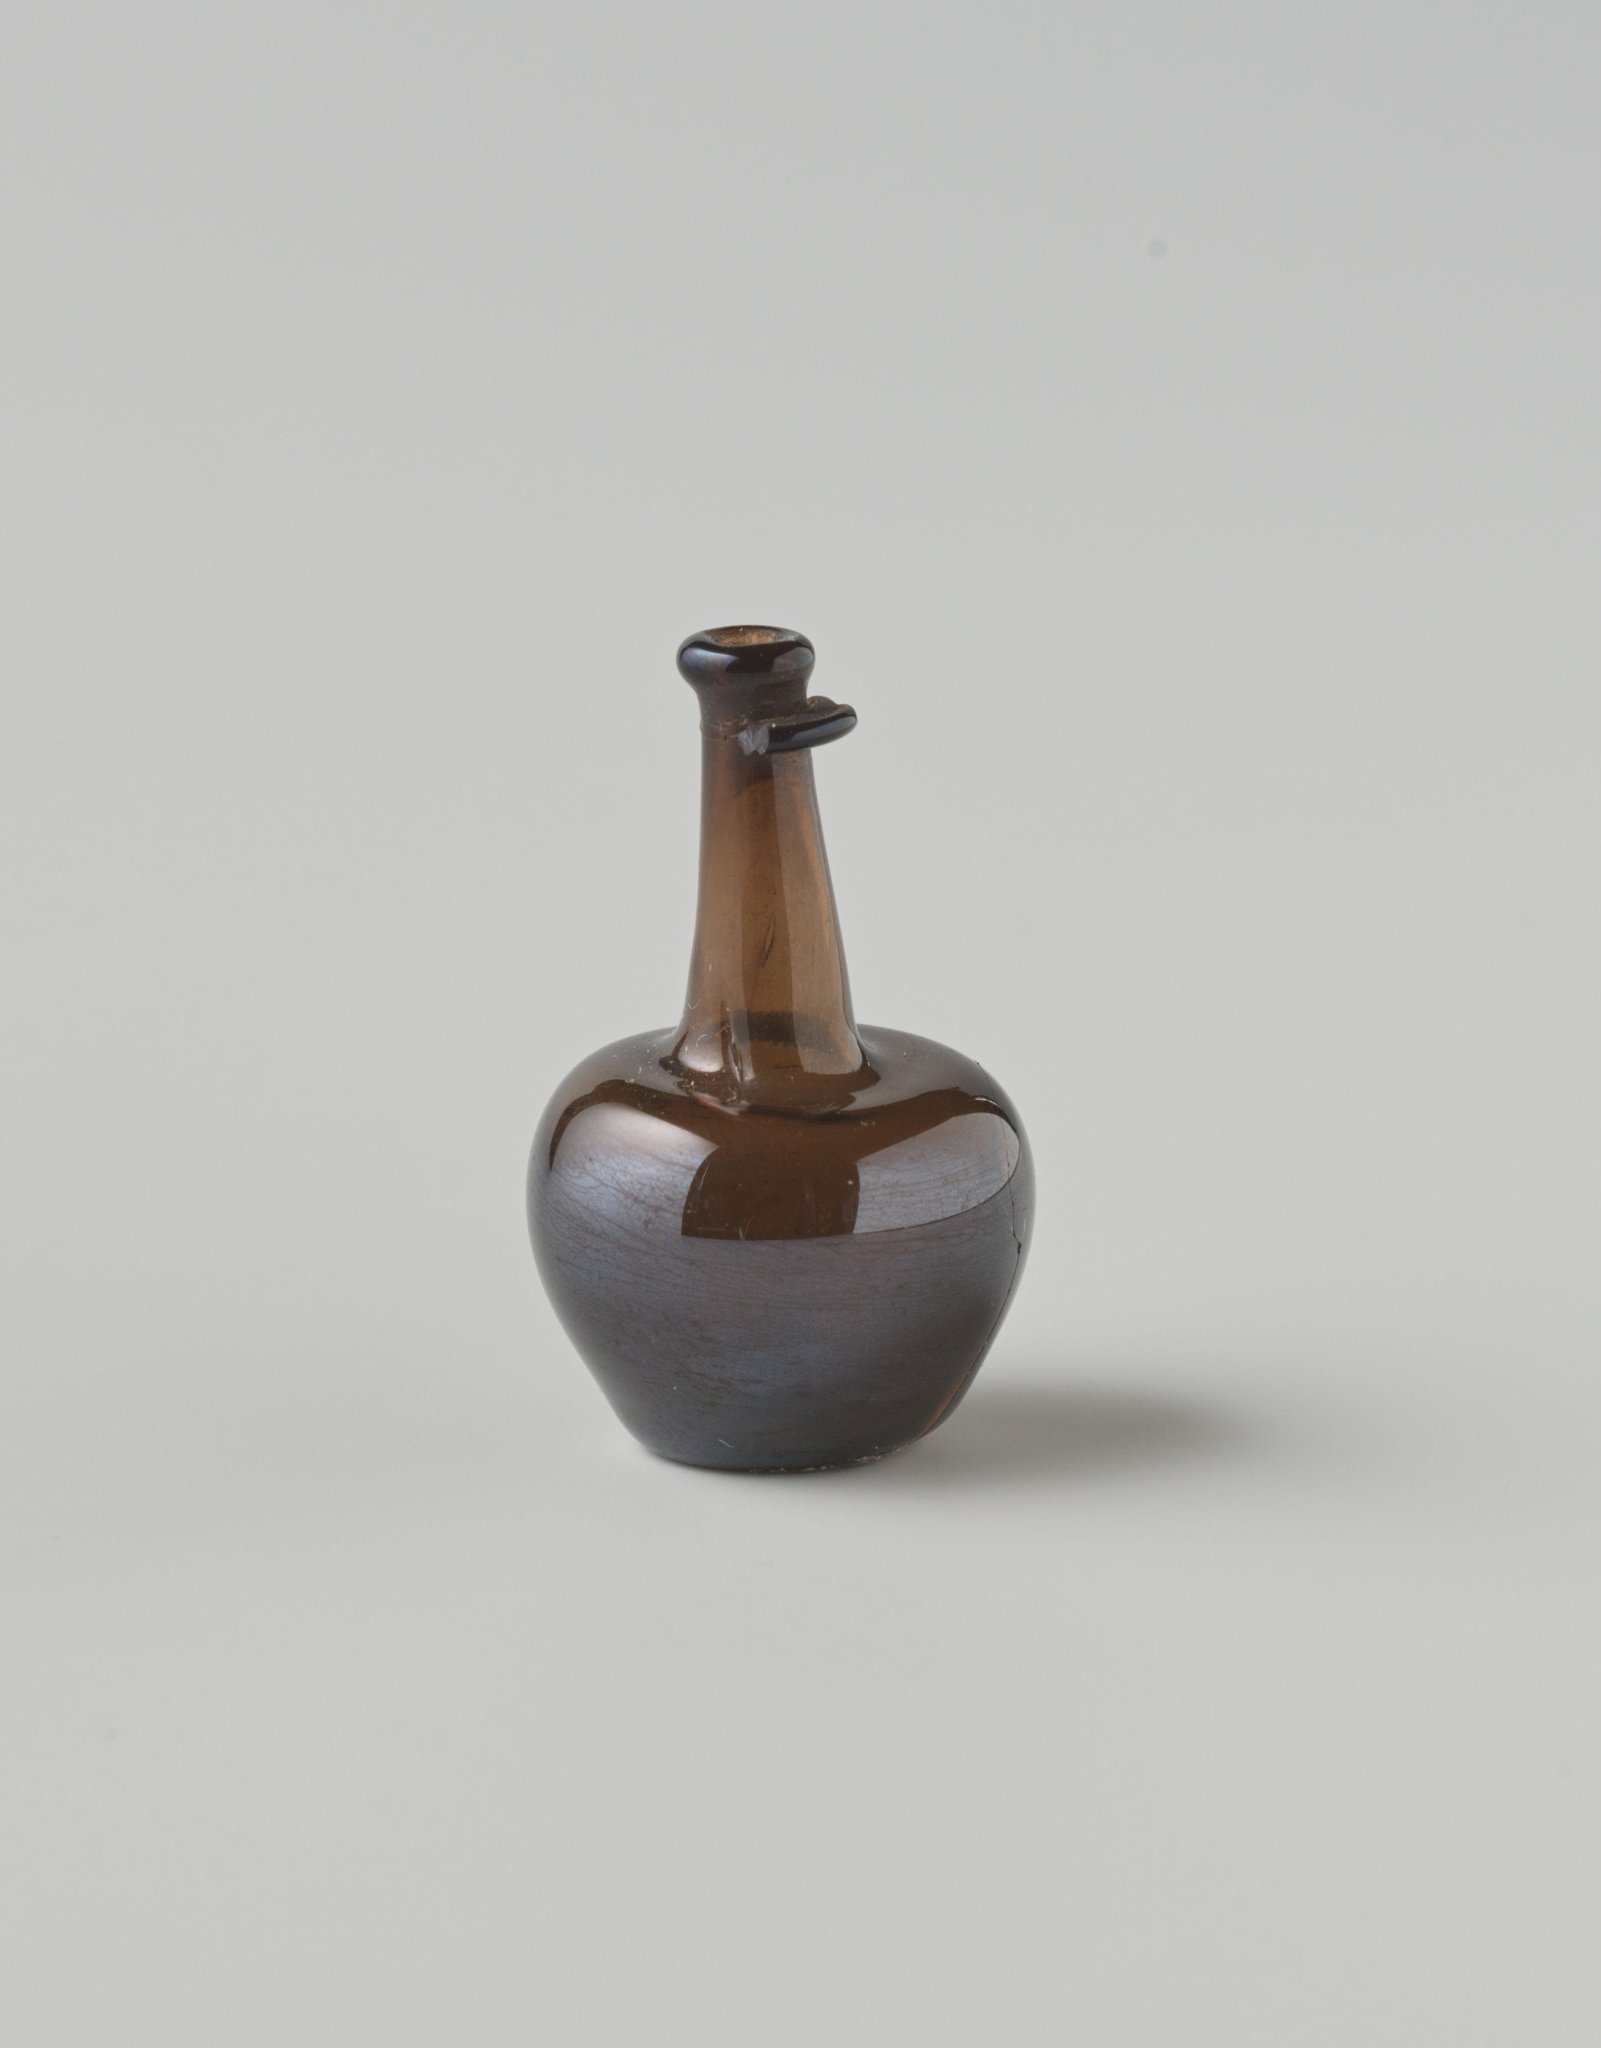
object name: miniature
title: Fles van helder azuurblauw glas; buik met ingestoken ziel, hoge hals met druipring (grotendeels afgebroken), in de halsopening een kurk.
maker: Anonymous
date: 1675-1710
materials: cork, glass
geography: amsterdam